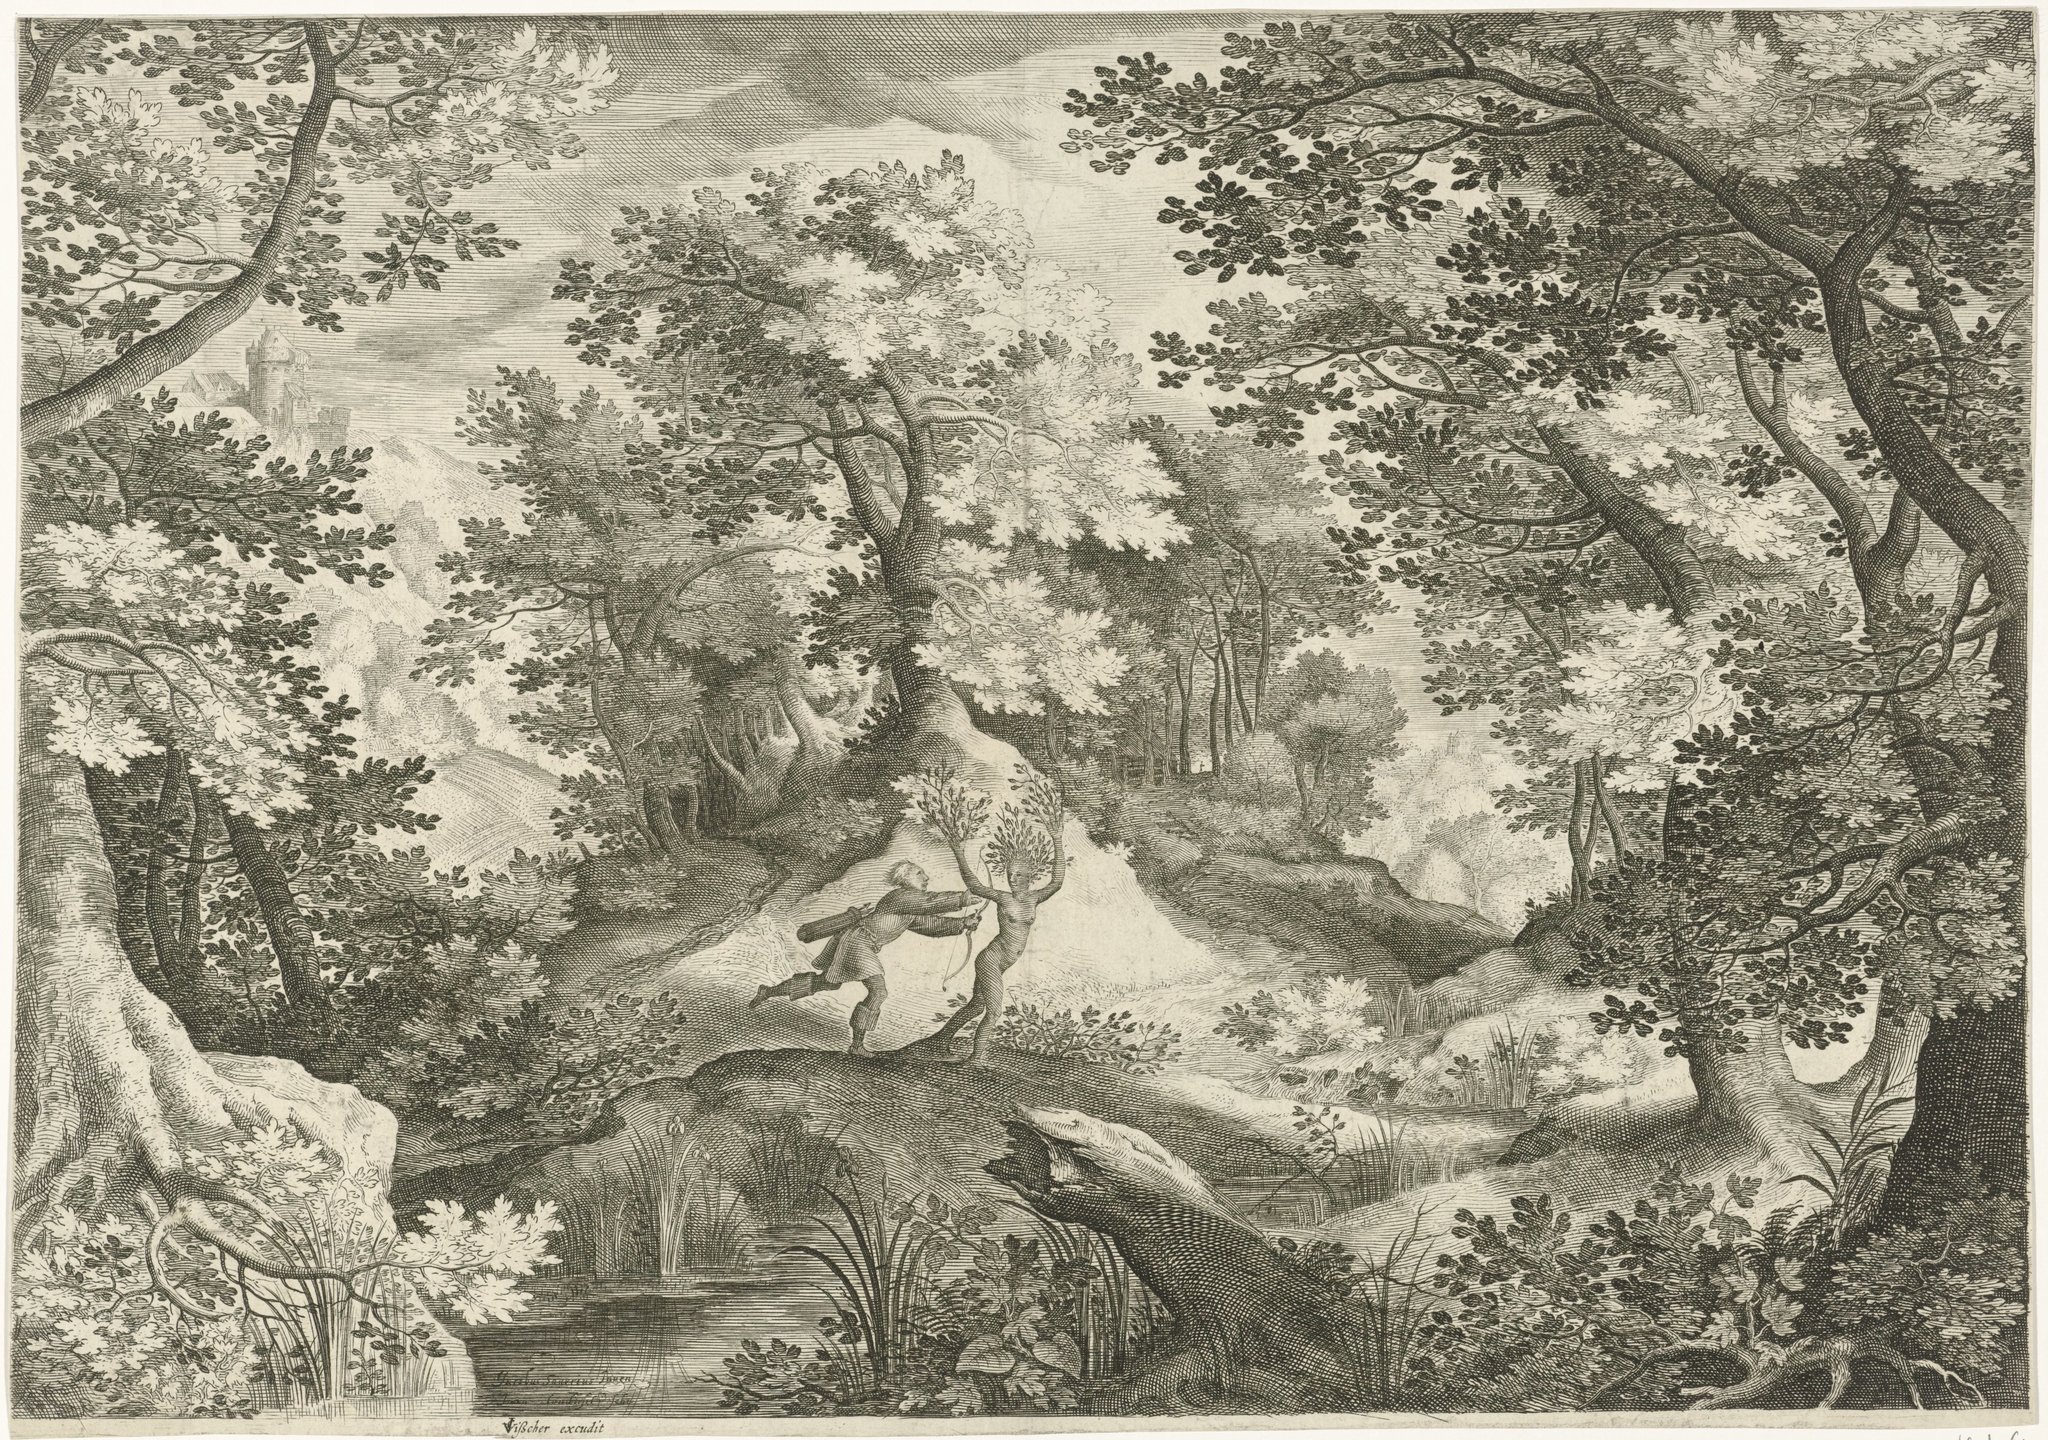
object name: print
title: Landschap met Apollo en Daphne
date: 1601-1652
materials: paper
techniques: engraving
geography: amsterdam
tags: forest, wood, daphne changed into a laurel-tree: while fleeing from apollo, daphne is changed into a laurel-tree by her father peneus (ovid, metamorphoses i 548)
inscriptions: collector's mark: Lugt 2228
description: In een bosrijk landschap achtervolgt Apollo, door een van Amors pijlen getroffen, de nimf Daphne. Laatstgenoemde roept haar vader om hulp en verandert terstond in een laurierboom.